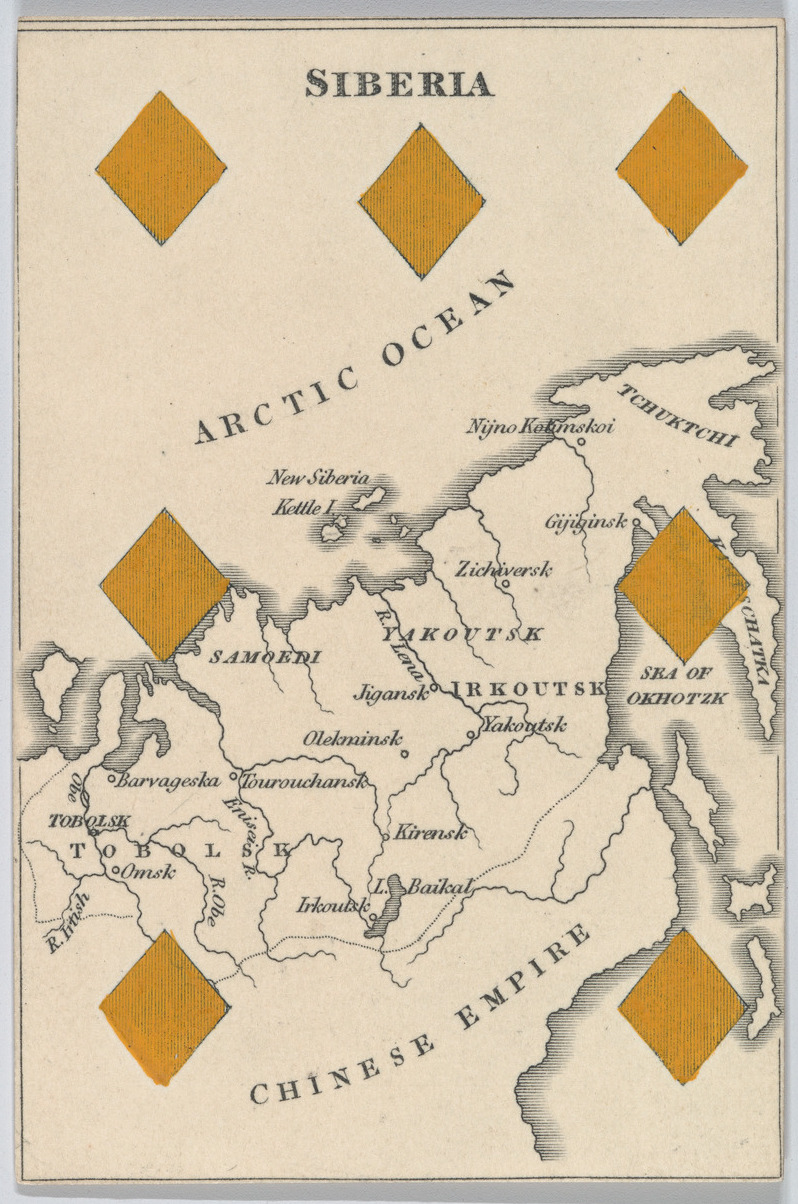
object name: print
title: Siberia in Asia, from "Court Game of Geography"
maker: william and henry rock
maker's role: publisher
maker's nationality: british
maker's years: 1821-1884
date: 1838-1855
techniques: engraving, hand coloring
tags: playing cards,maps